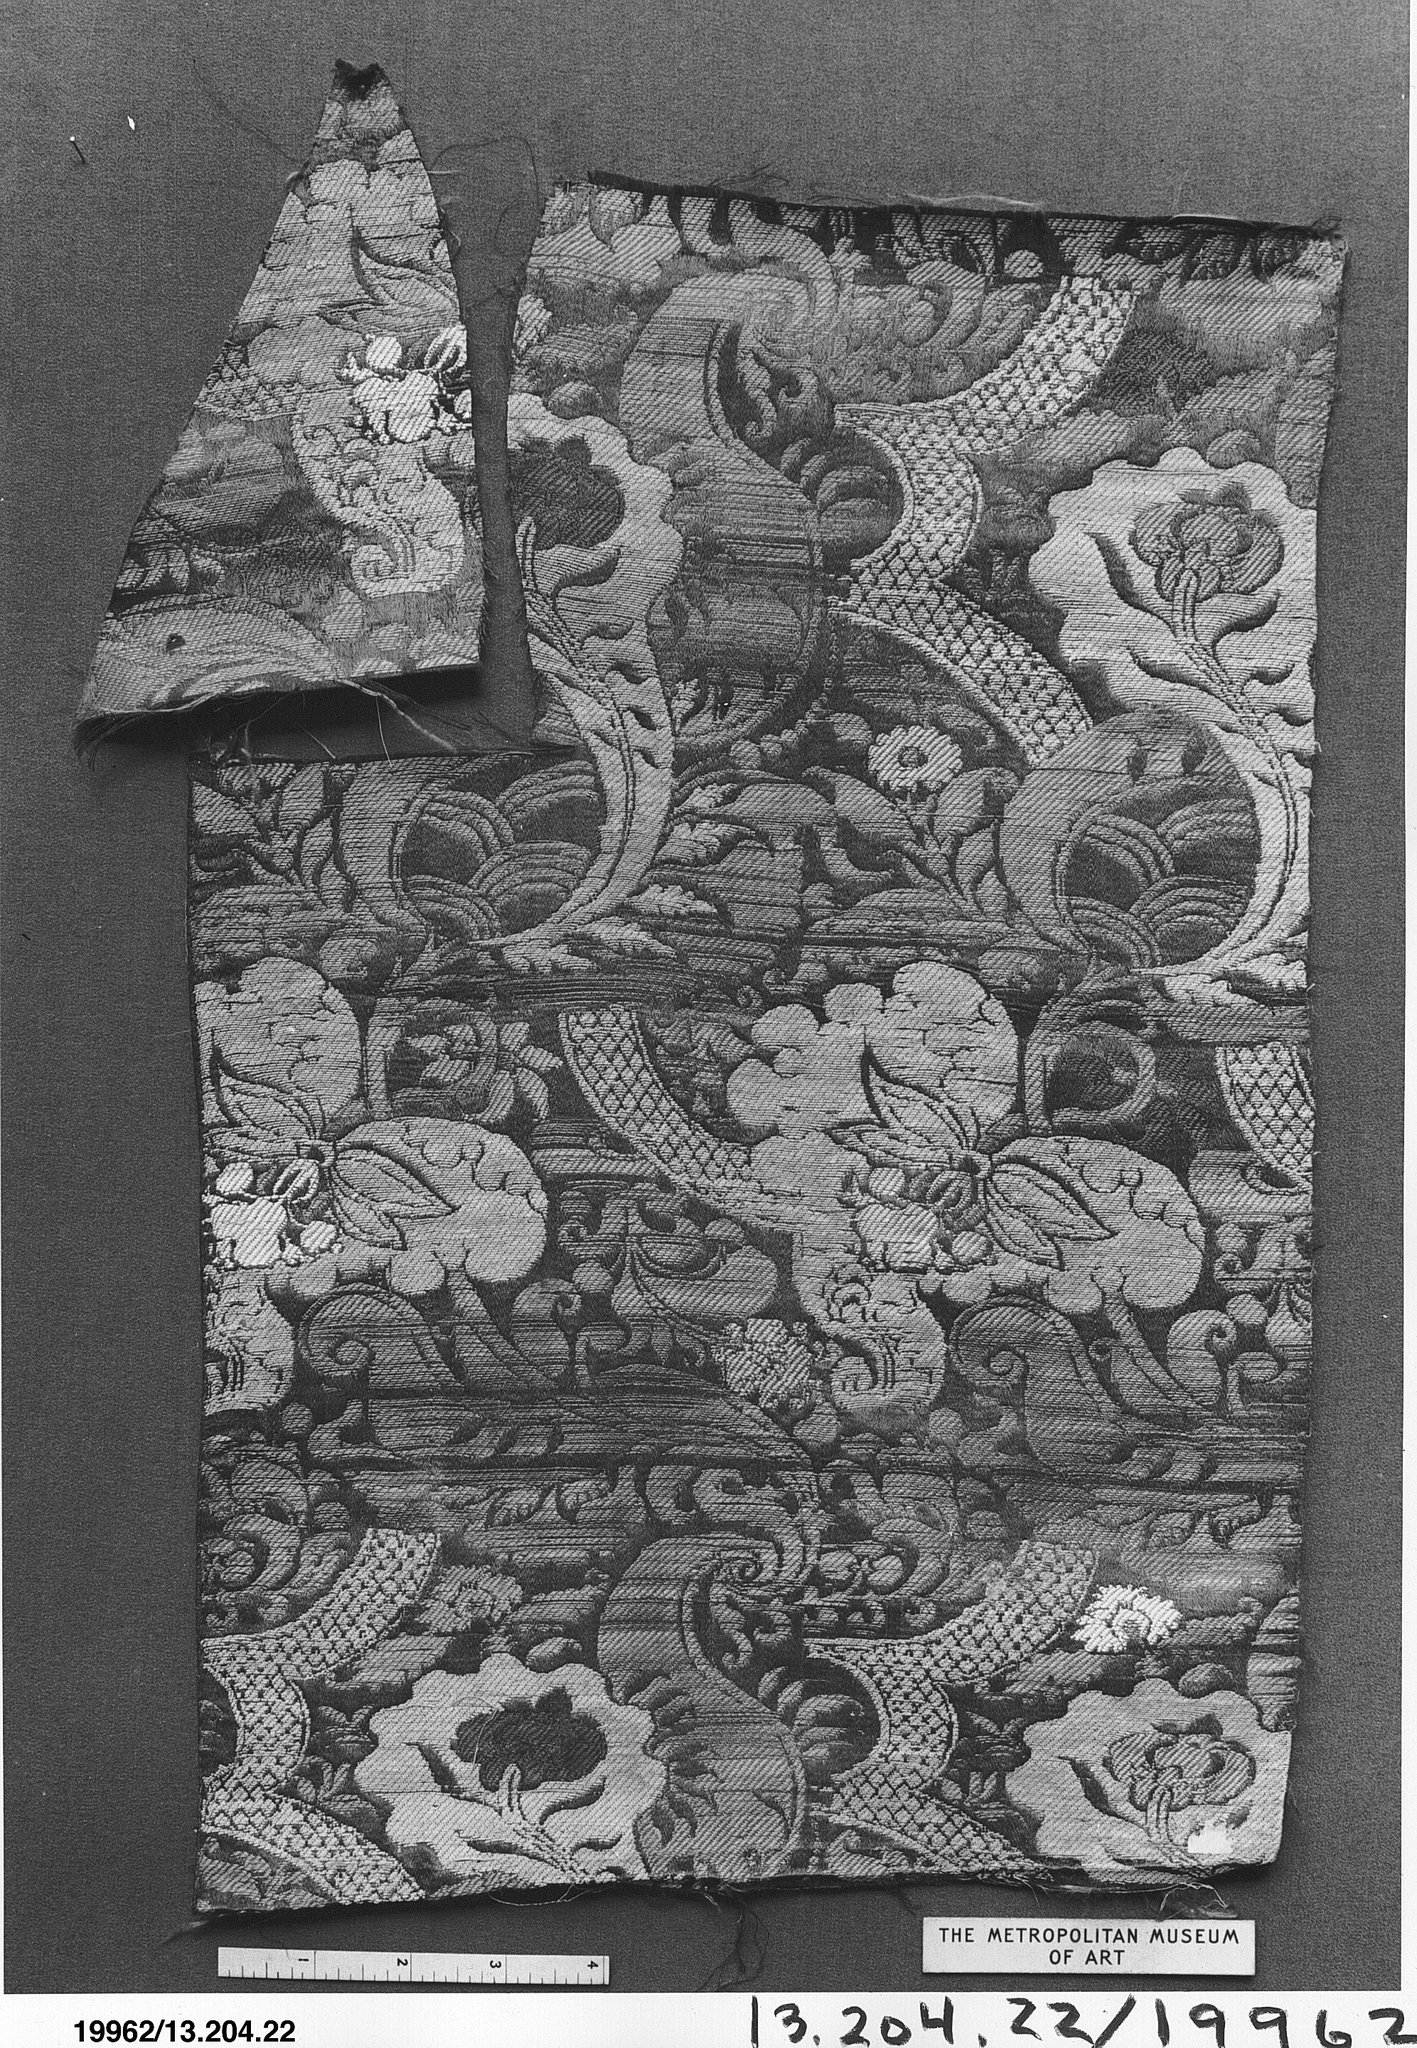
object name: piece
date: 1701-1733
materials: silk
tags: flowers,leaves